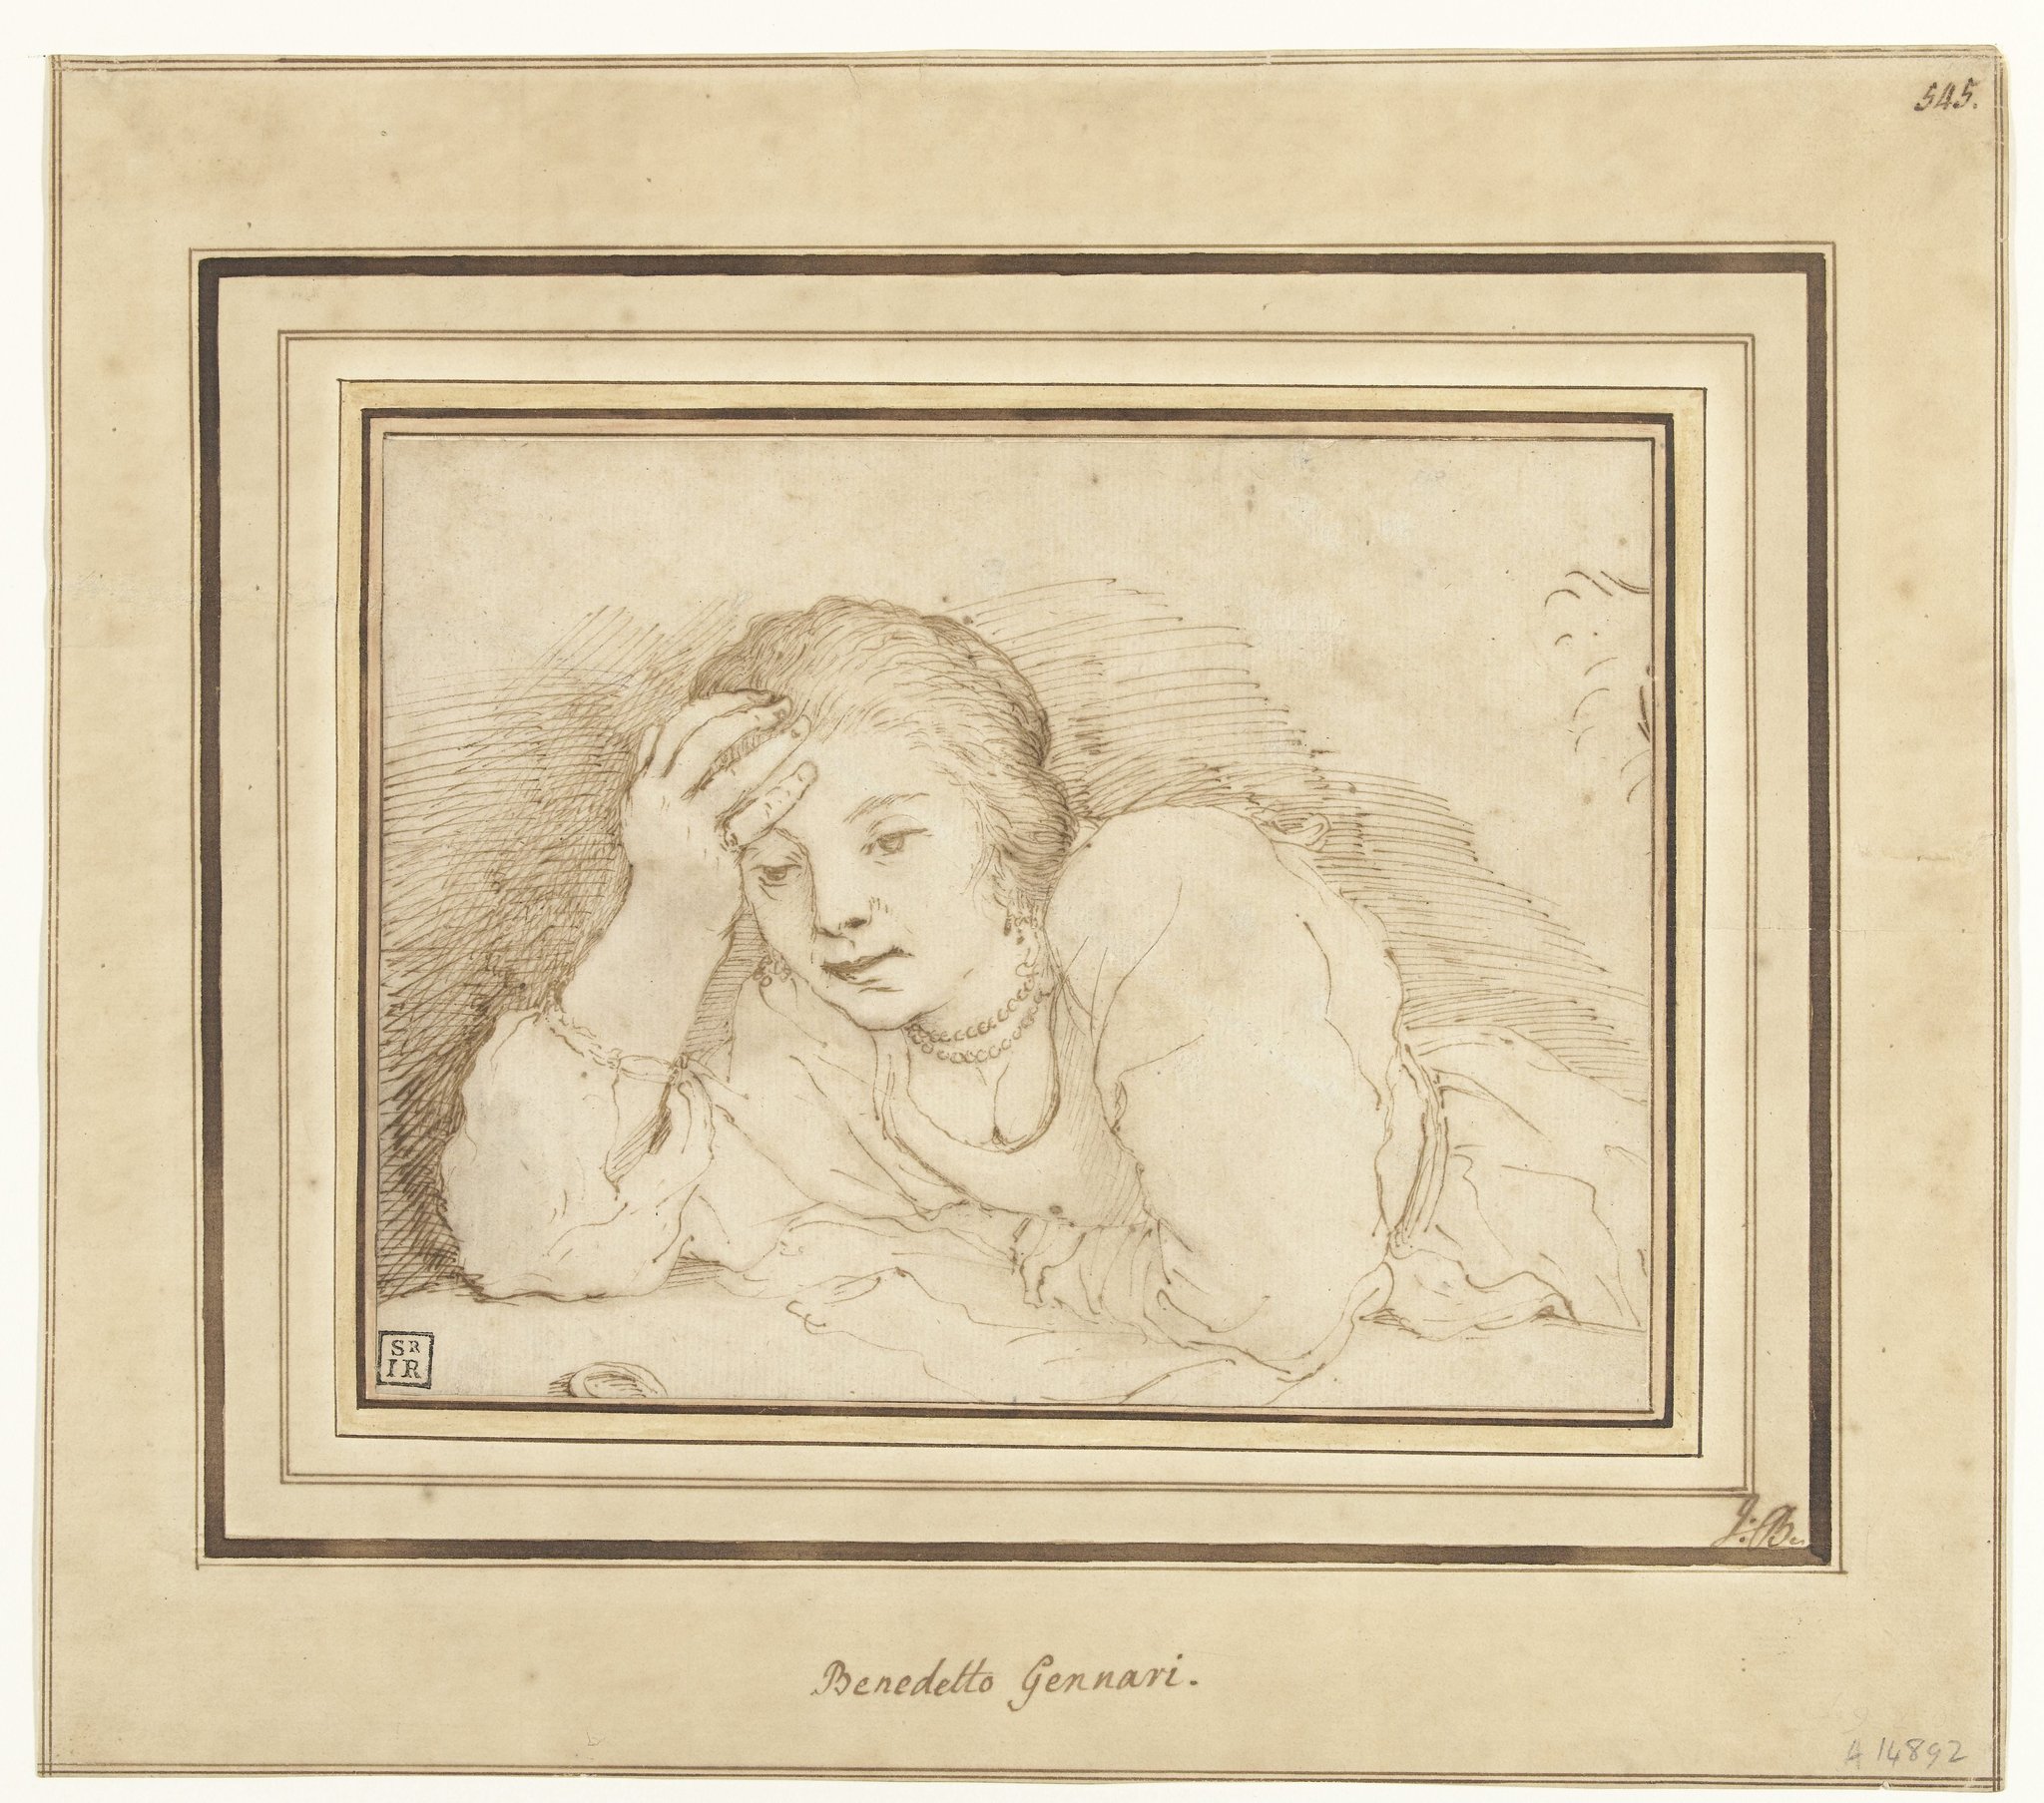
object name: drawing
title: Studie van een over een tafel leunende jonge vrouw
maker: benedetto gennari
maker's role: draughtsman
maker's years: 1633-1715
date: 1643-1715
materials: ink, paper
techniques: pen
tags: adolescent, young woman, maiden, sitting figure - aa - female human figure, leaning forward - aa - female human figure